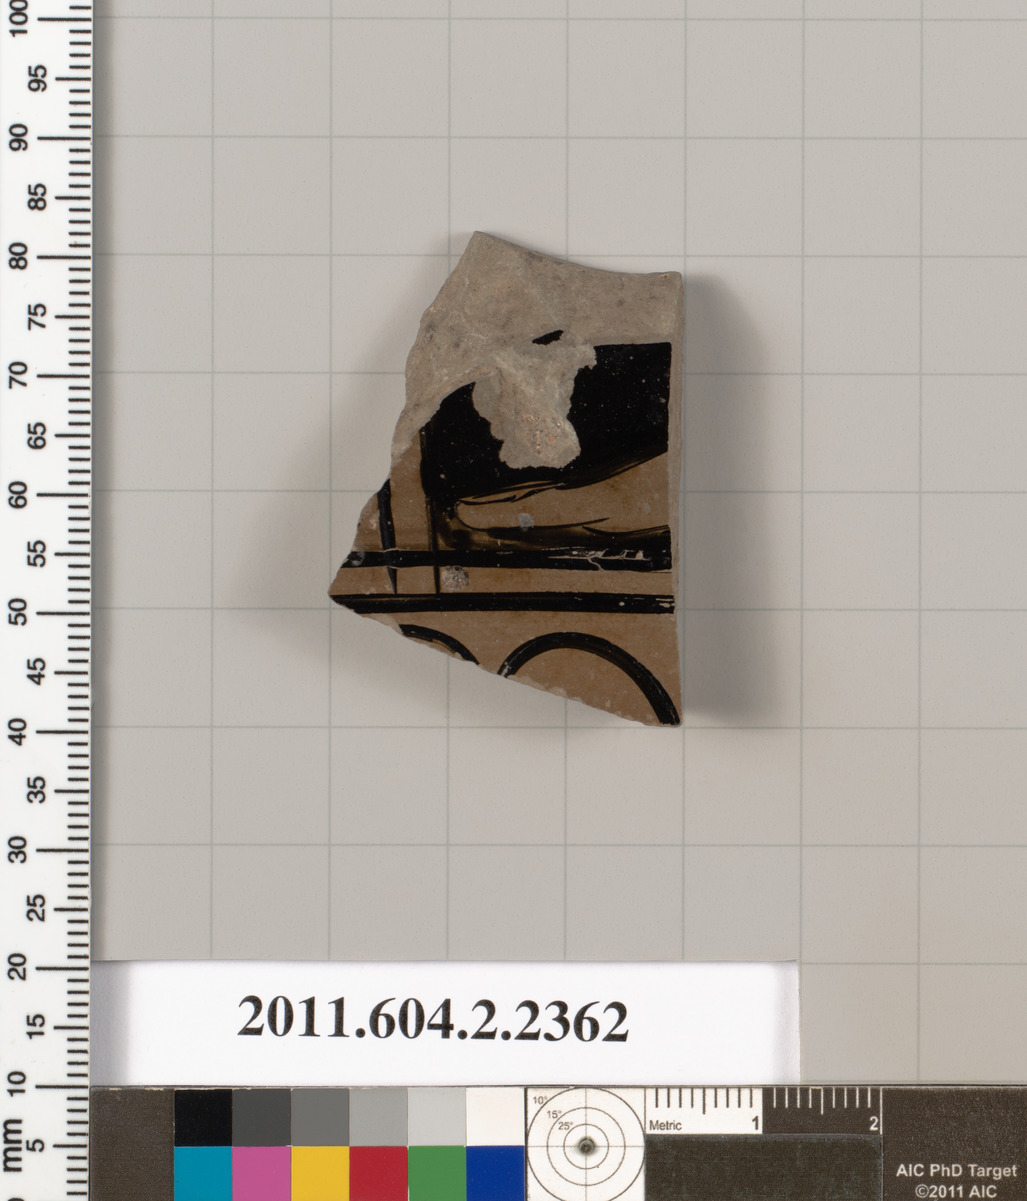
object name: pot fragment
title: Terracotta fragment of a pot; unglazed on the inside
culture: greek, attic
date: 460-450 BCE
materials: terracotta